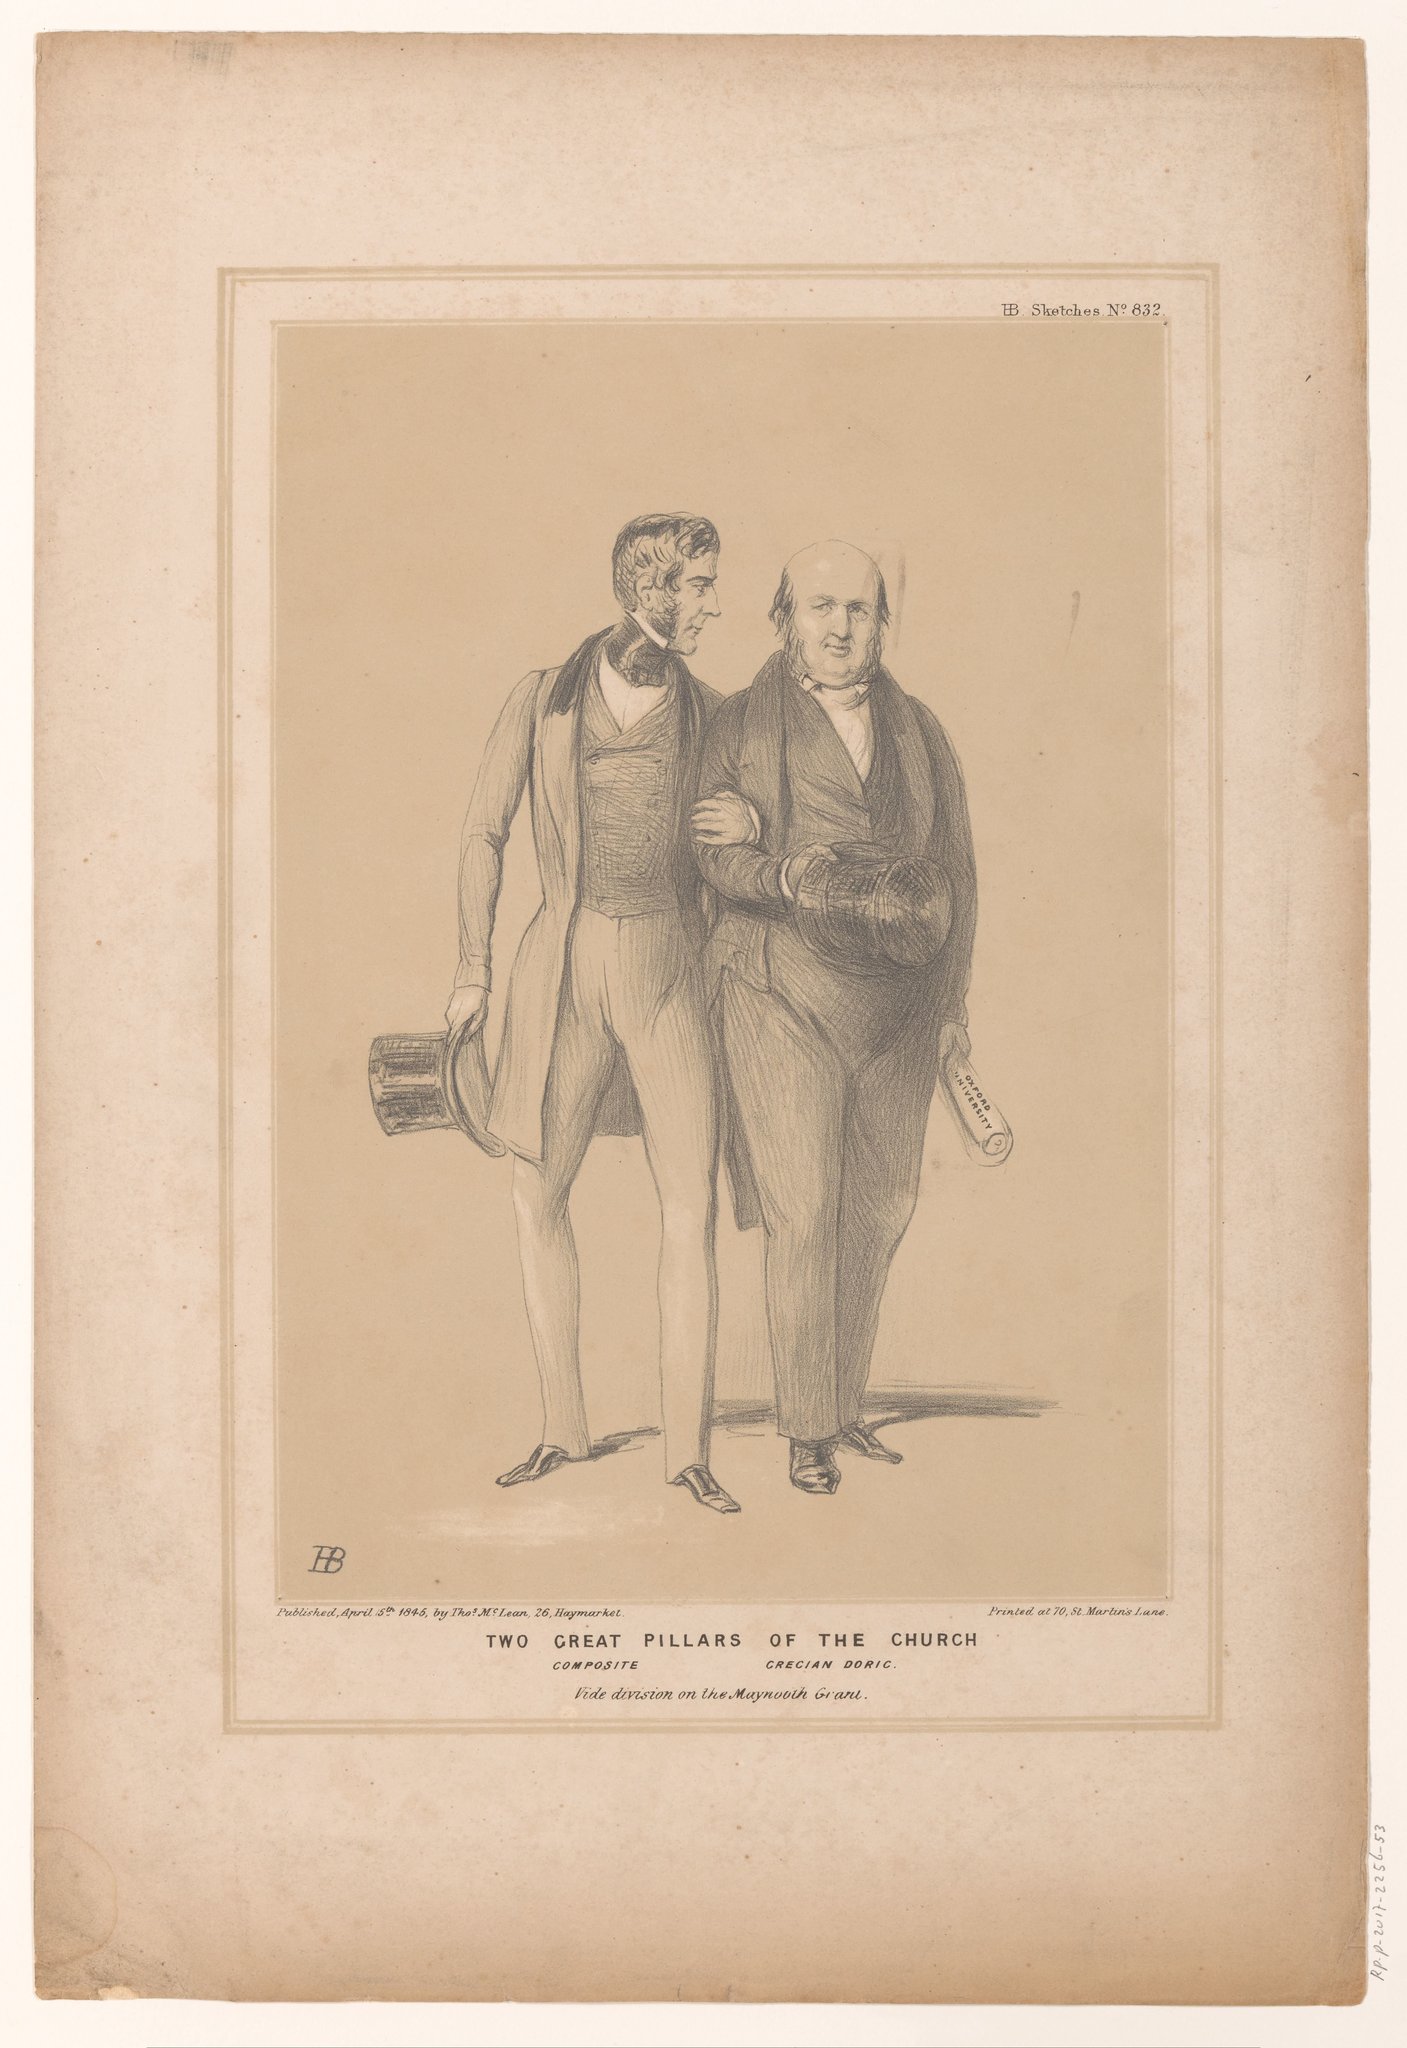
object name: print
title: Spotprent op de Engelse binnenlandse politiek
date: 1845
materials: paper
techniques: tone lithography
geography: london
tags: political caricatures and satires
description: Spotprent uit 1845 op de Engelse binnenlandse politiek. Twee heren als de steunpilaren van de kerk. Uitgegeven als nr. 832 in de serie HB Sketches.